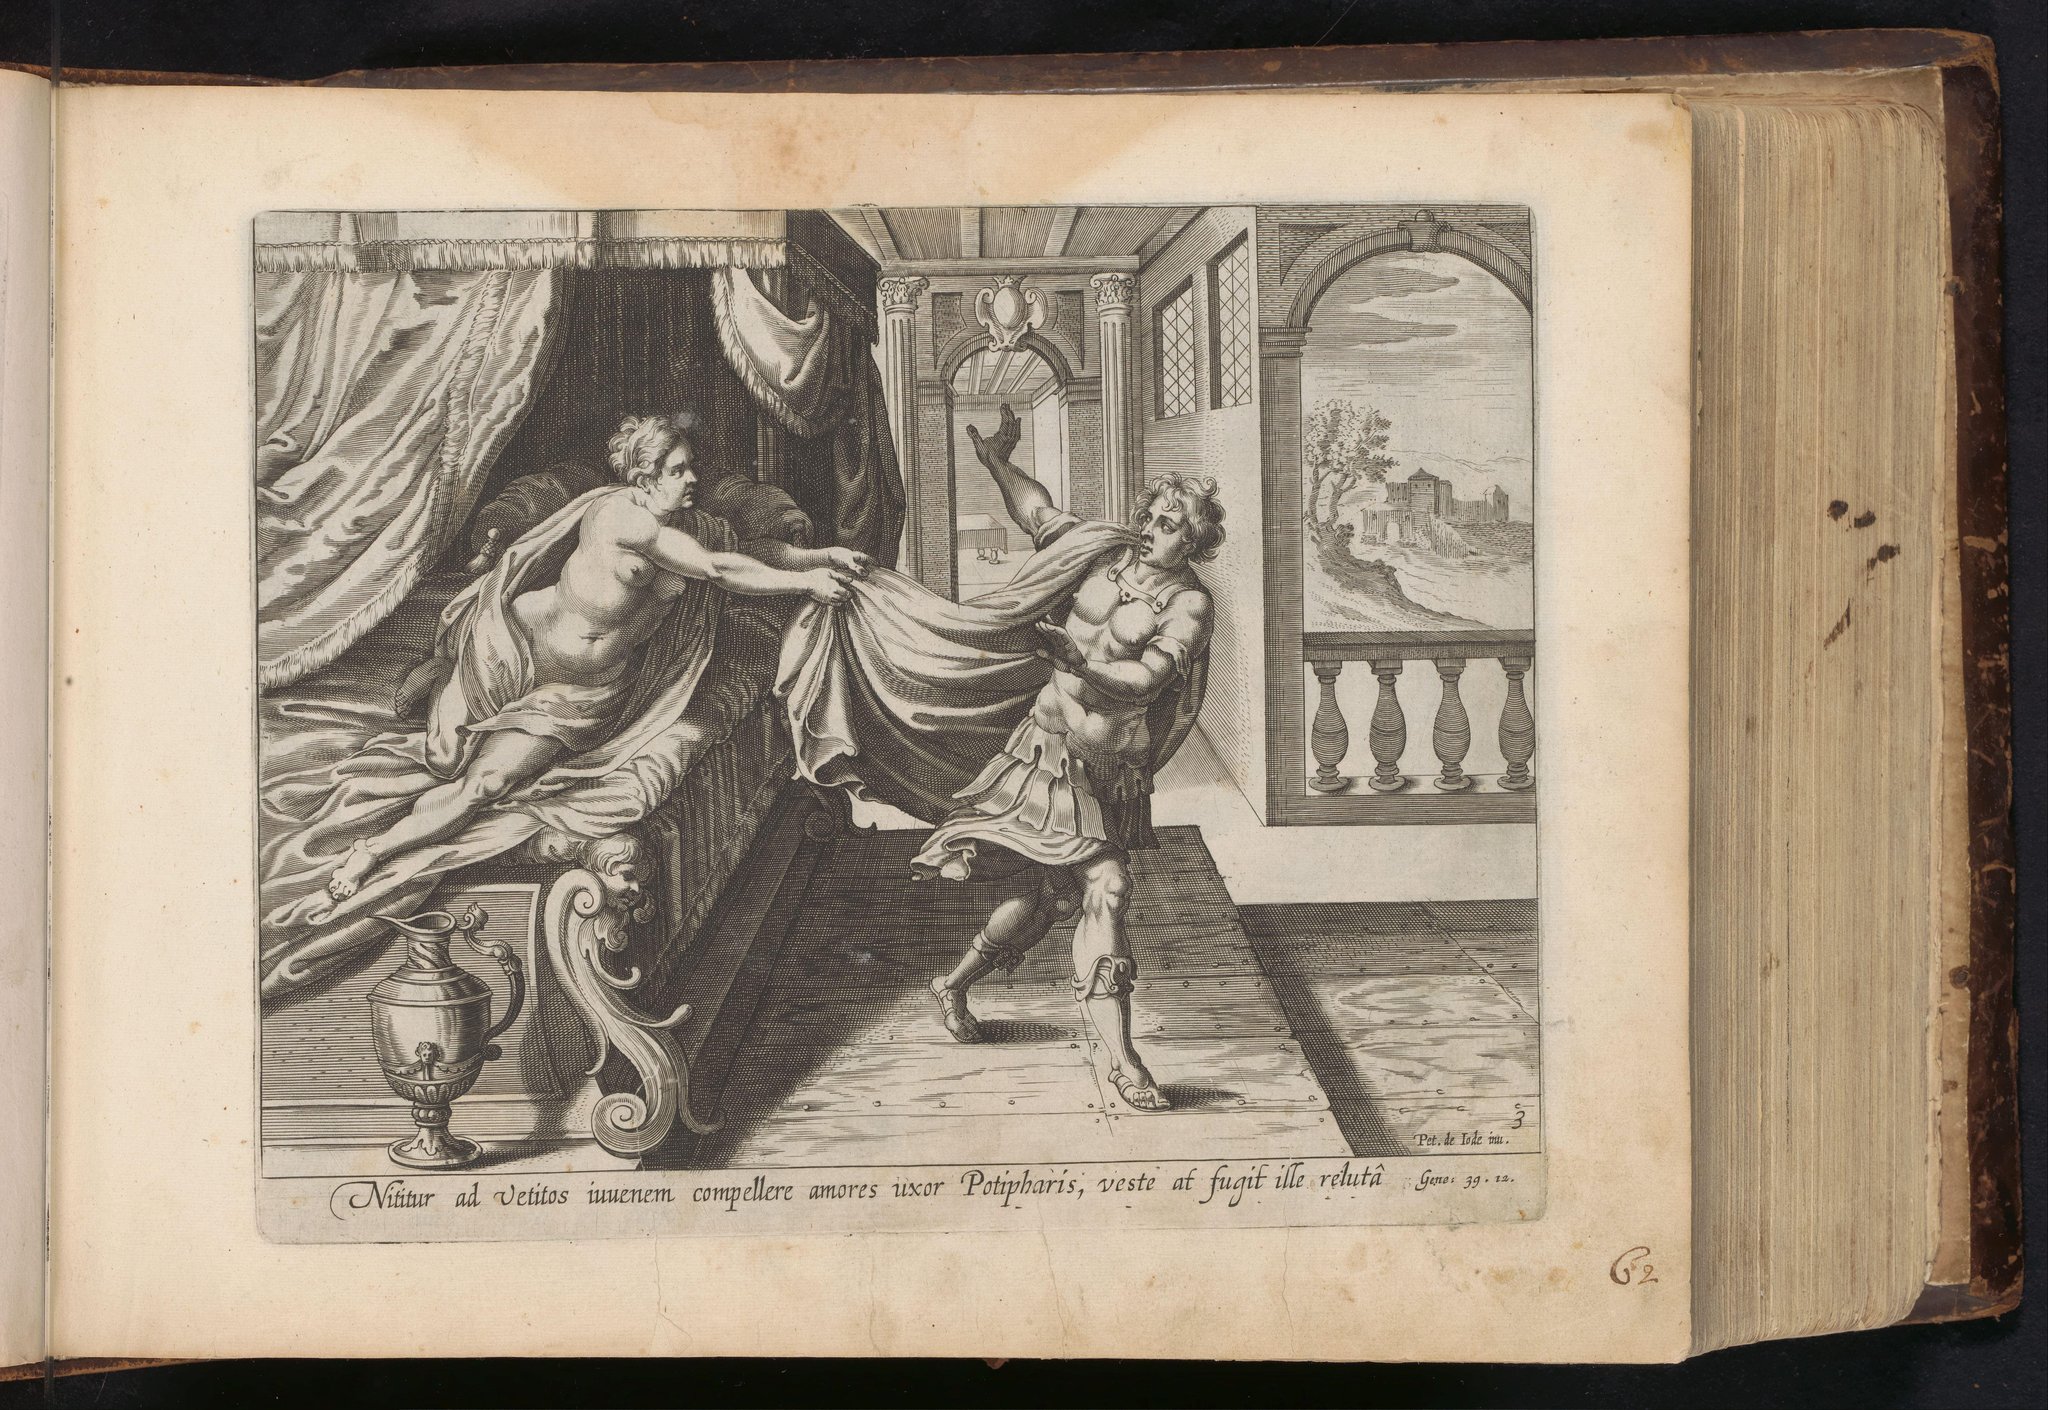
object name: album leaf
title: Den Grooten Figuer-Bibel (...)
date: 1579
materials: paper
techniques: engraving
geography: alkmaar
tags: potiphar's wife catches joseph by his robe, usually while lying in bed; joseph escapes leaving his cloak behind in her hands (possibly with a naked child lying in a crib)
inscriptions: number: ‘62’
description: Jozef vlucht voor de vrouw van Potifar, die in bed ligt en hem probeert te verleiden. Zij grijpt zijn kleed vast. Onder de voorstelling een verwijzing in het Latijn naar de Bijbeltekst in Gen. 39:12. Deze prent maakt deel uit van een album.